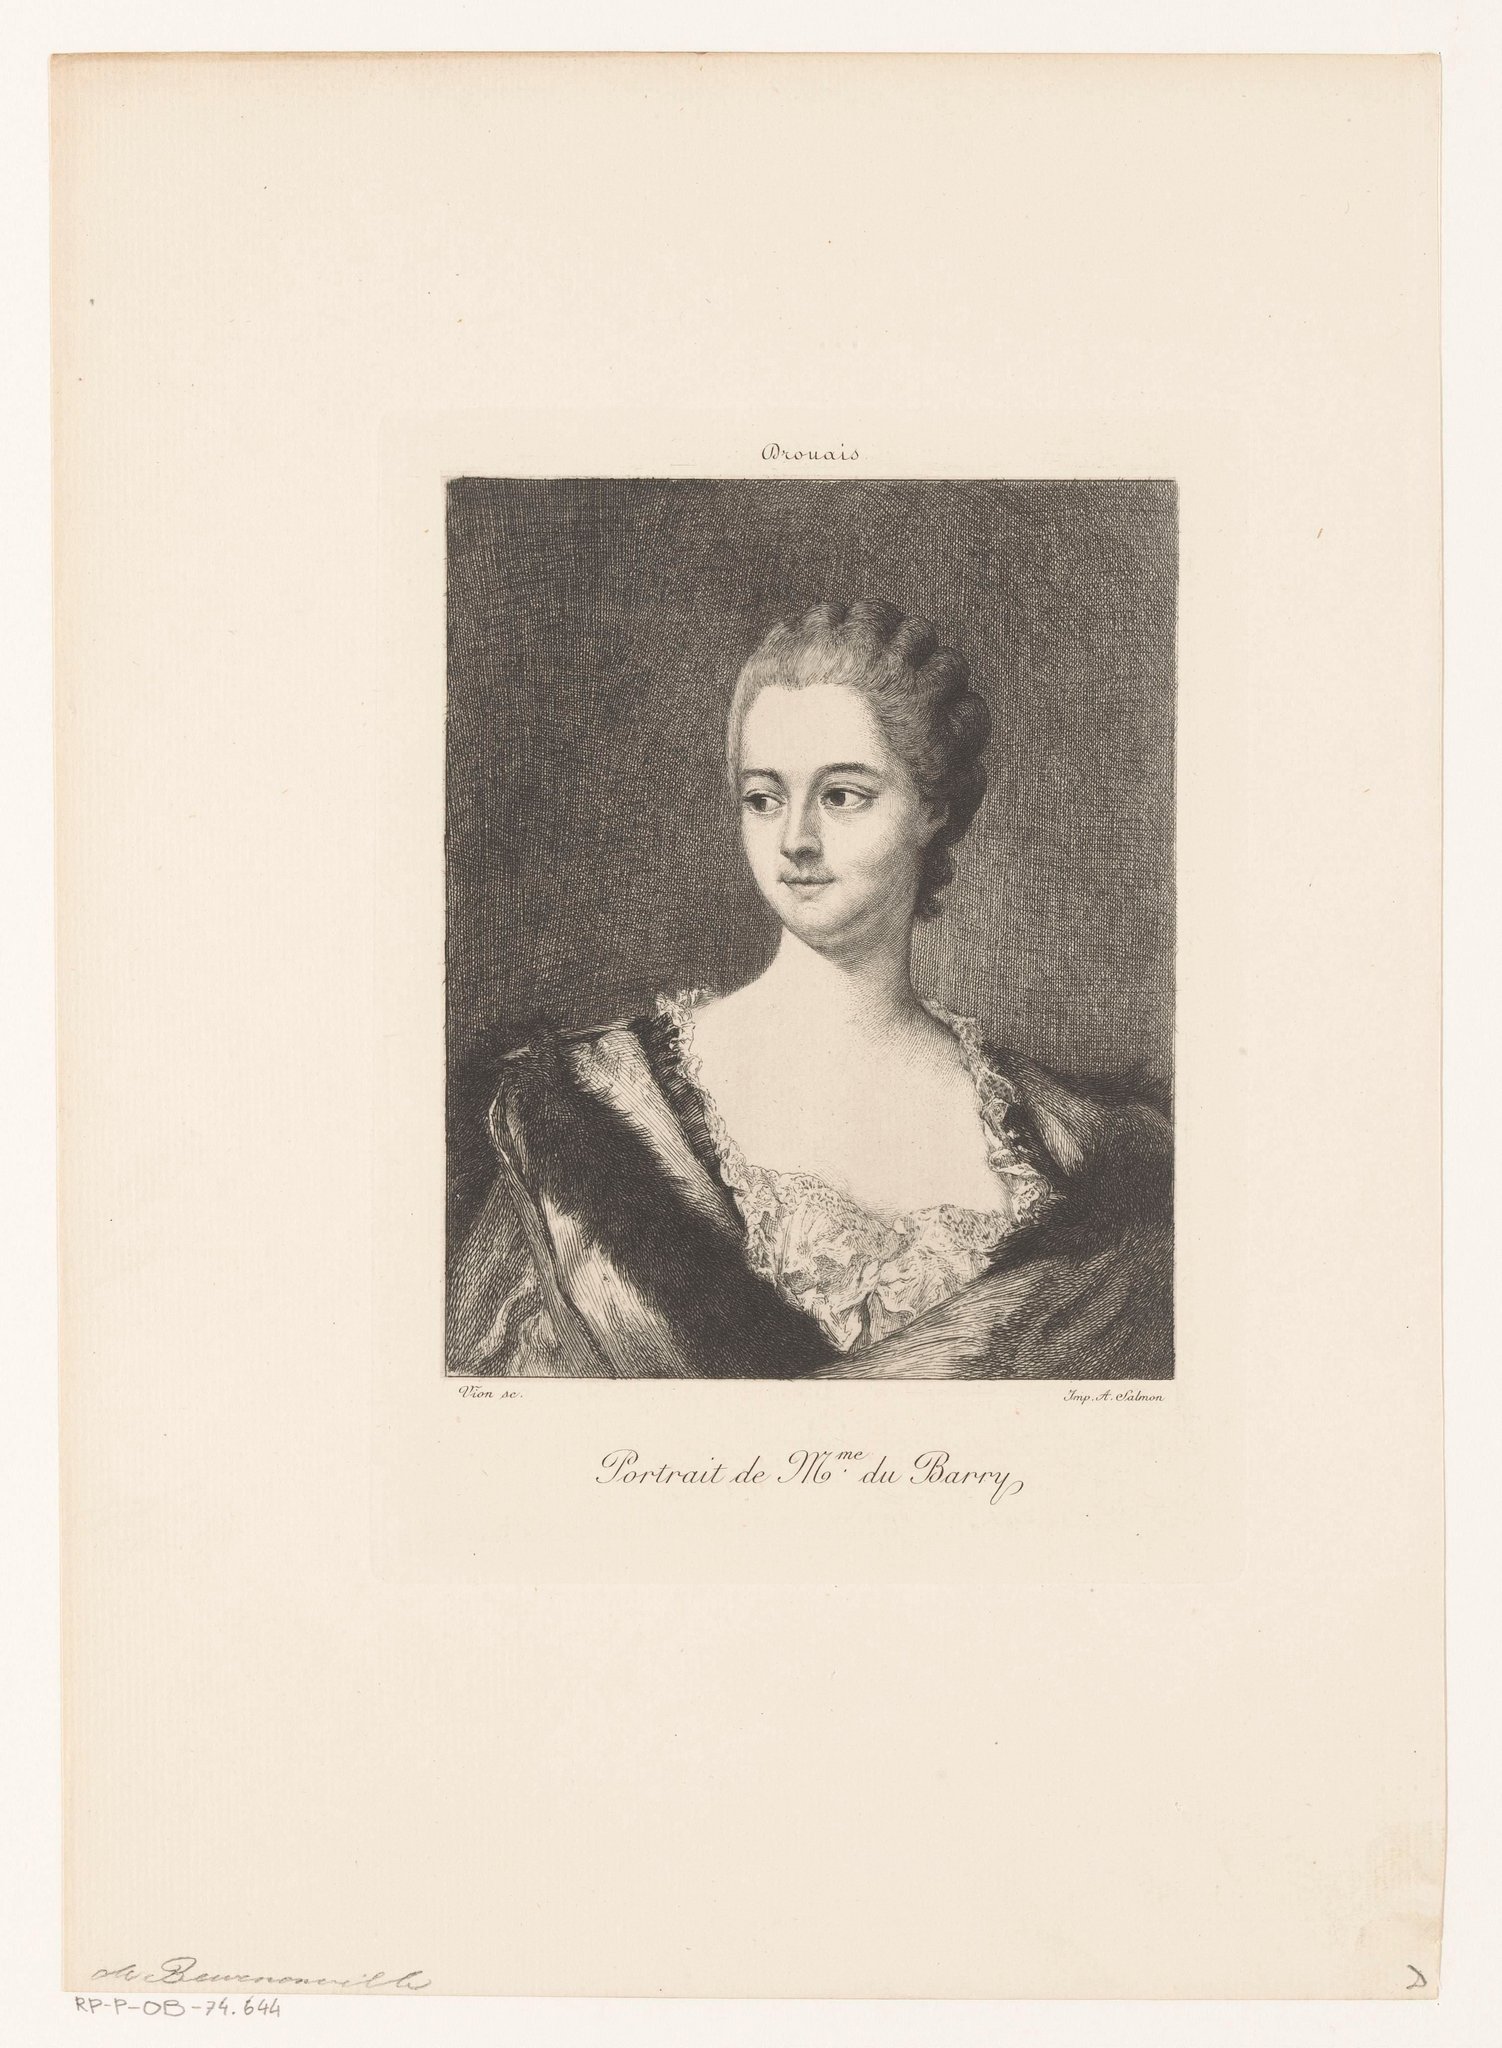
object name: print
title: Portret van Madame du Barry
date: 1873-1894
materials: paper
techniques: engraving, etching, intaglio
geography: paris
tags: historical persons, mistress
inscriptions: collector's mark: Lugt 2228